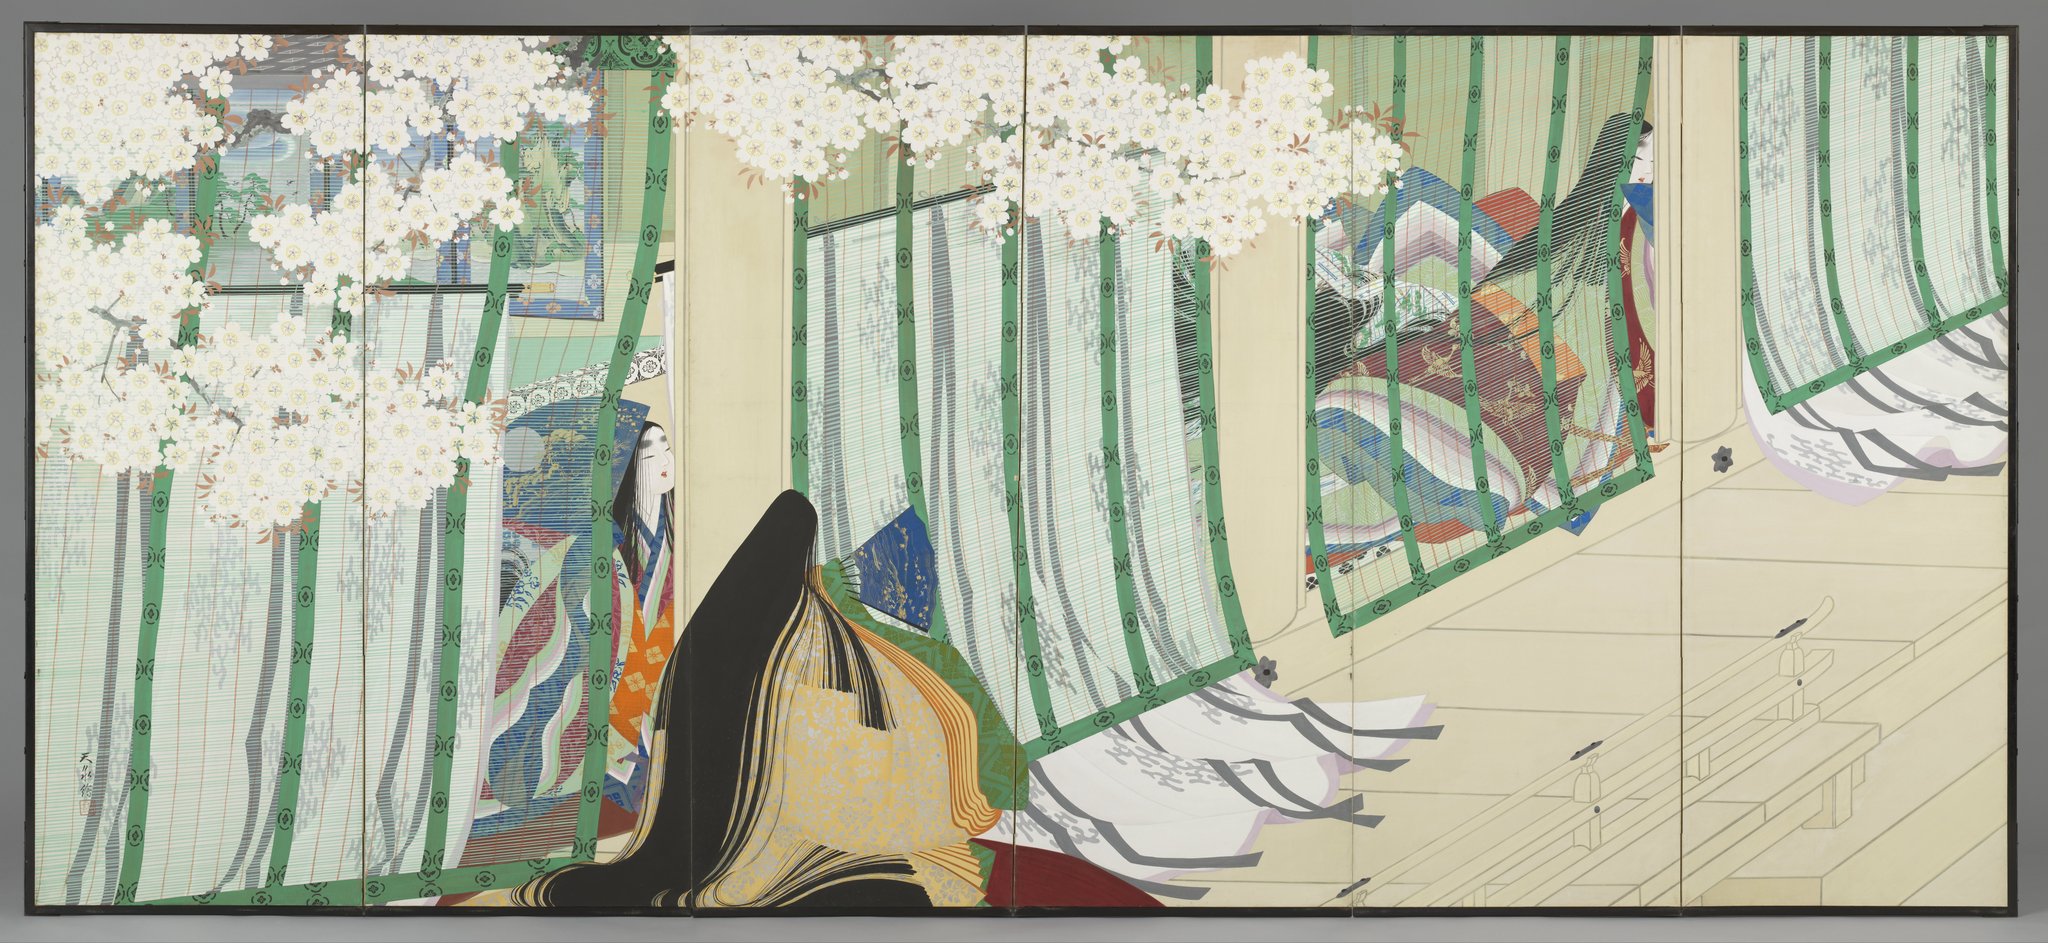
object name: vouwscherm, kamerscherm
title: Folding Screen The Bamboo River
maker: ogyu tensen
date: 1915-1940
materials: dye, ink, silk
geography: tokyo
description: In the chapter The Bamboo River in the early 11th-century novel The Tale of Genji, Kaoru, Genji’s 15-year-old stepson, visits the three daughters of Tamakazura, who were considered ‘unruly’. He wanted to practice the skills he felt were required of a young man. However, suddenly two robes are placed over his shoulders, and he dashes off in confusion.